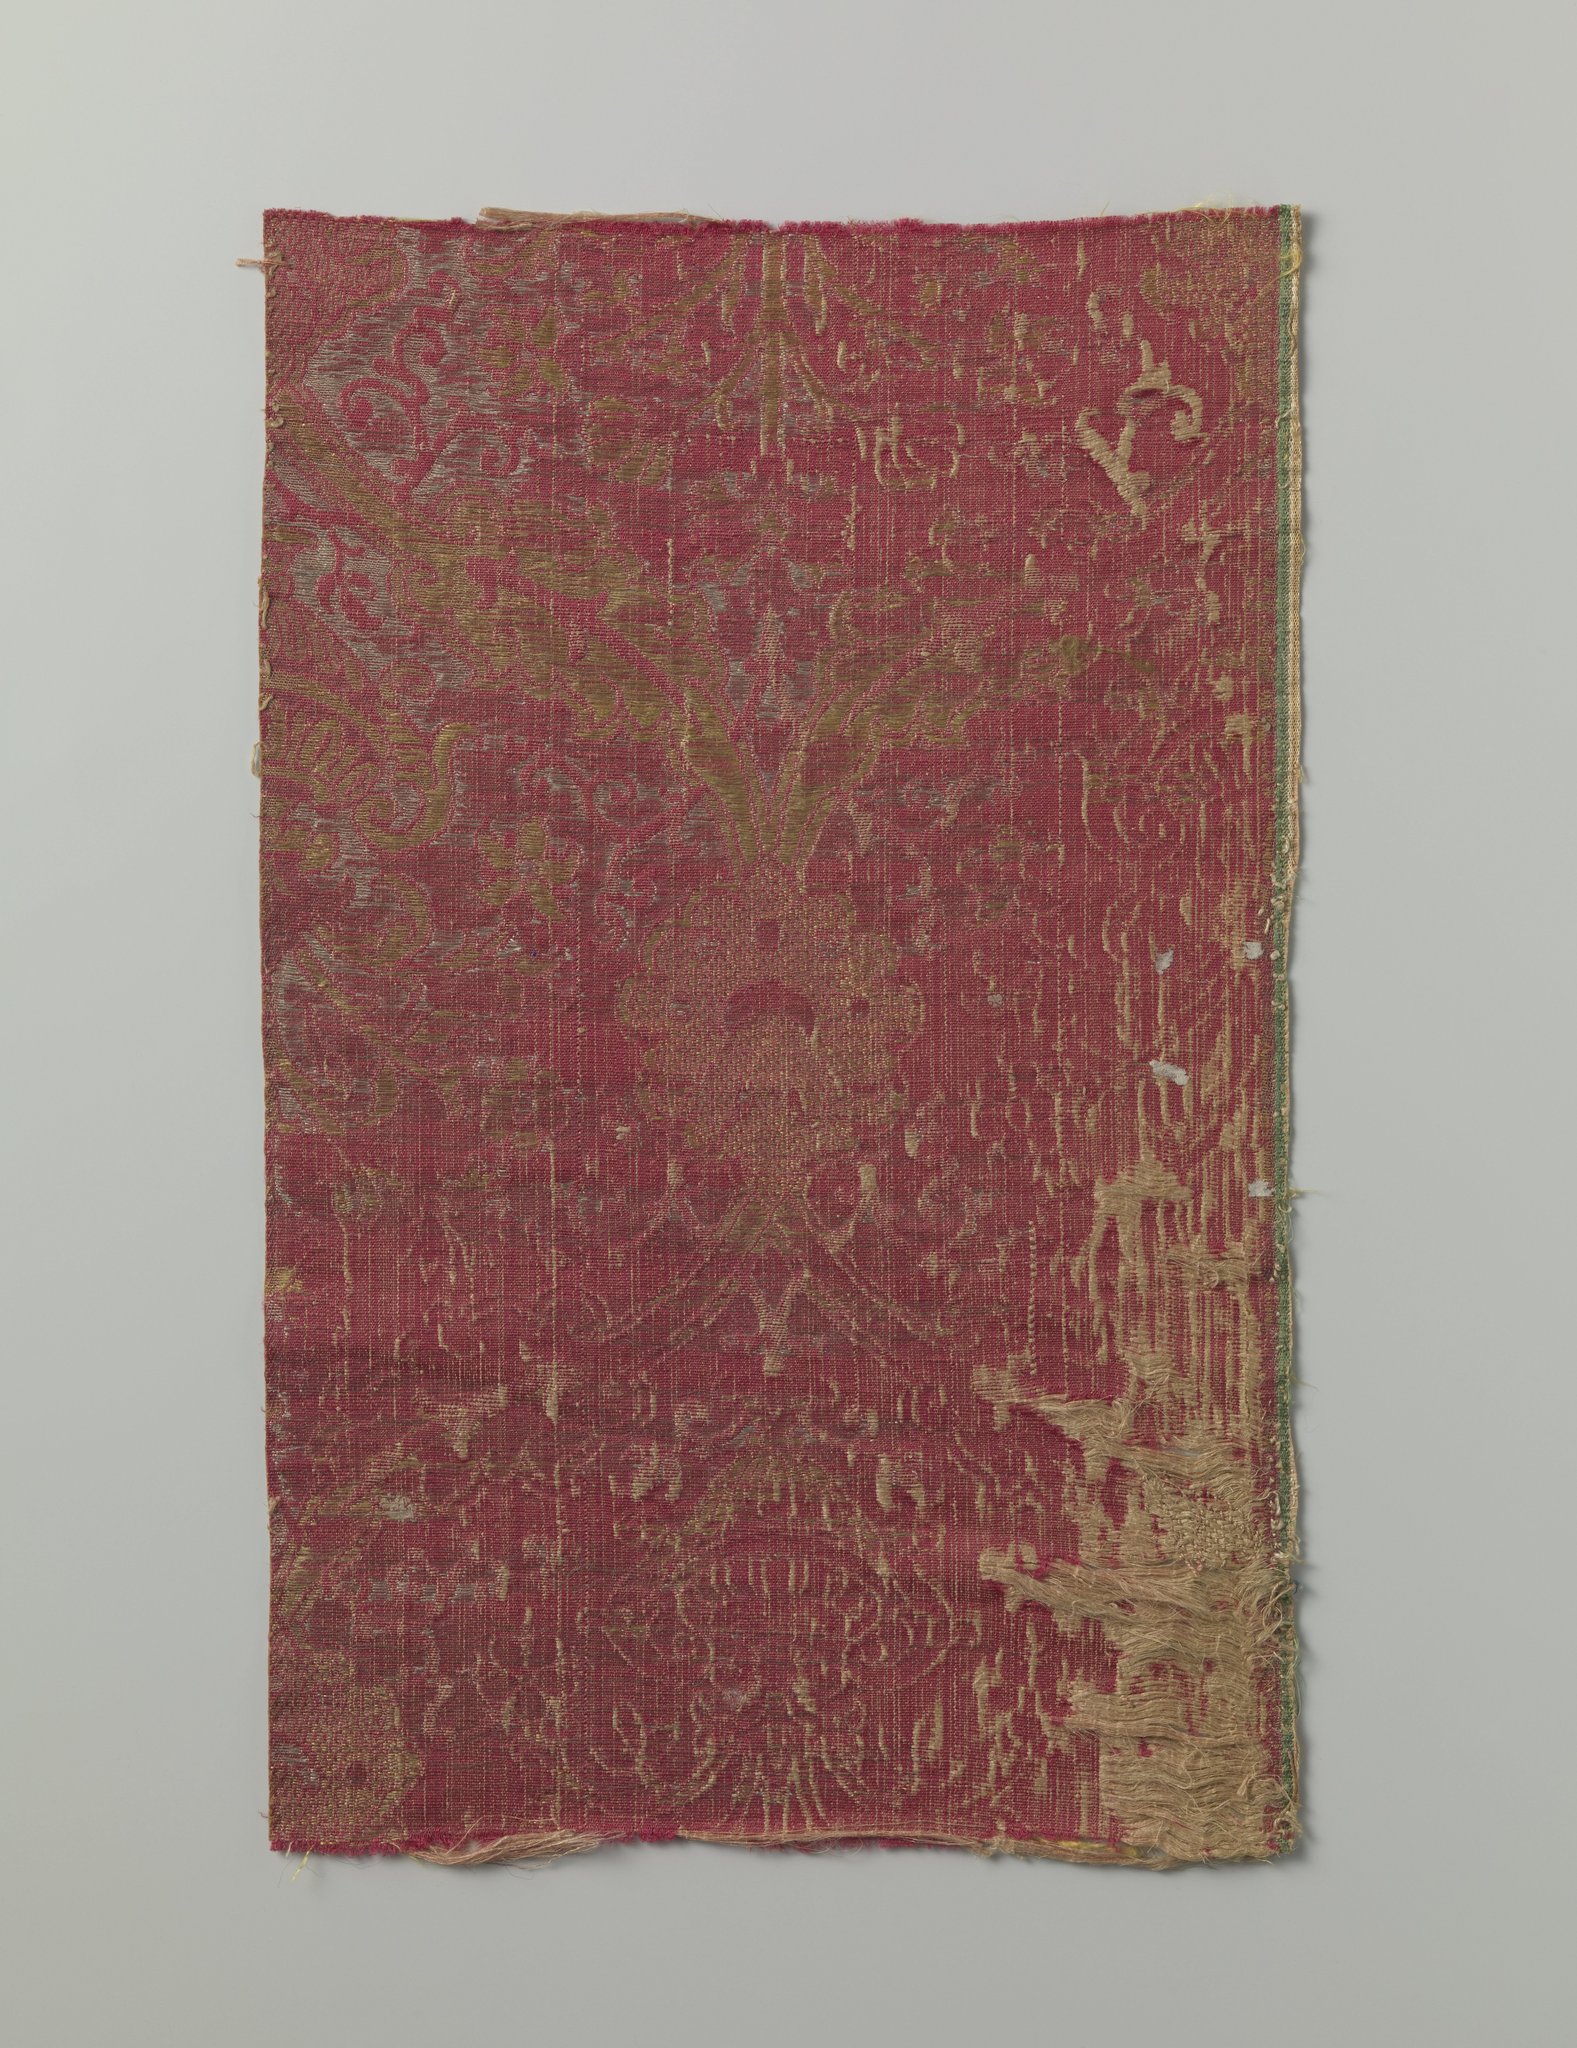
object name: fragment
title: Fragment rode brocatel met granaatappelmotief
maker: Anonymous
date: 1400-1599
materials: textile, linen, metal thread, silk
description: Fragment met bloemmotief in spitsovalen in rood en zilver (?). Zelfkant groen wit geel gestreept.